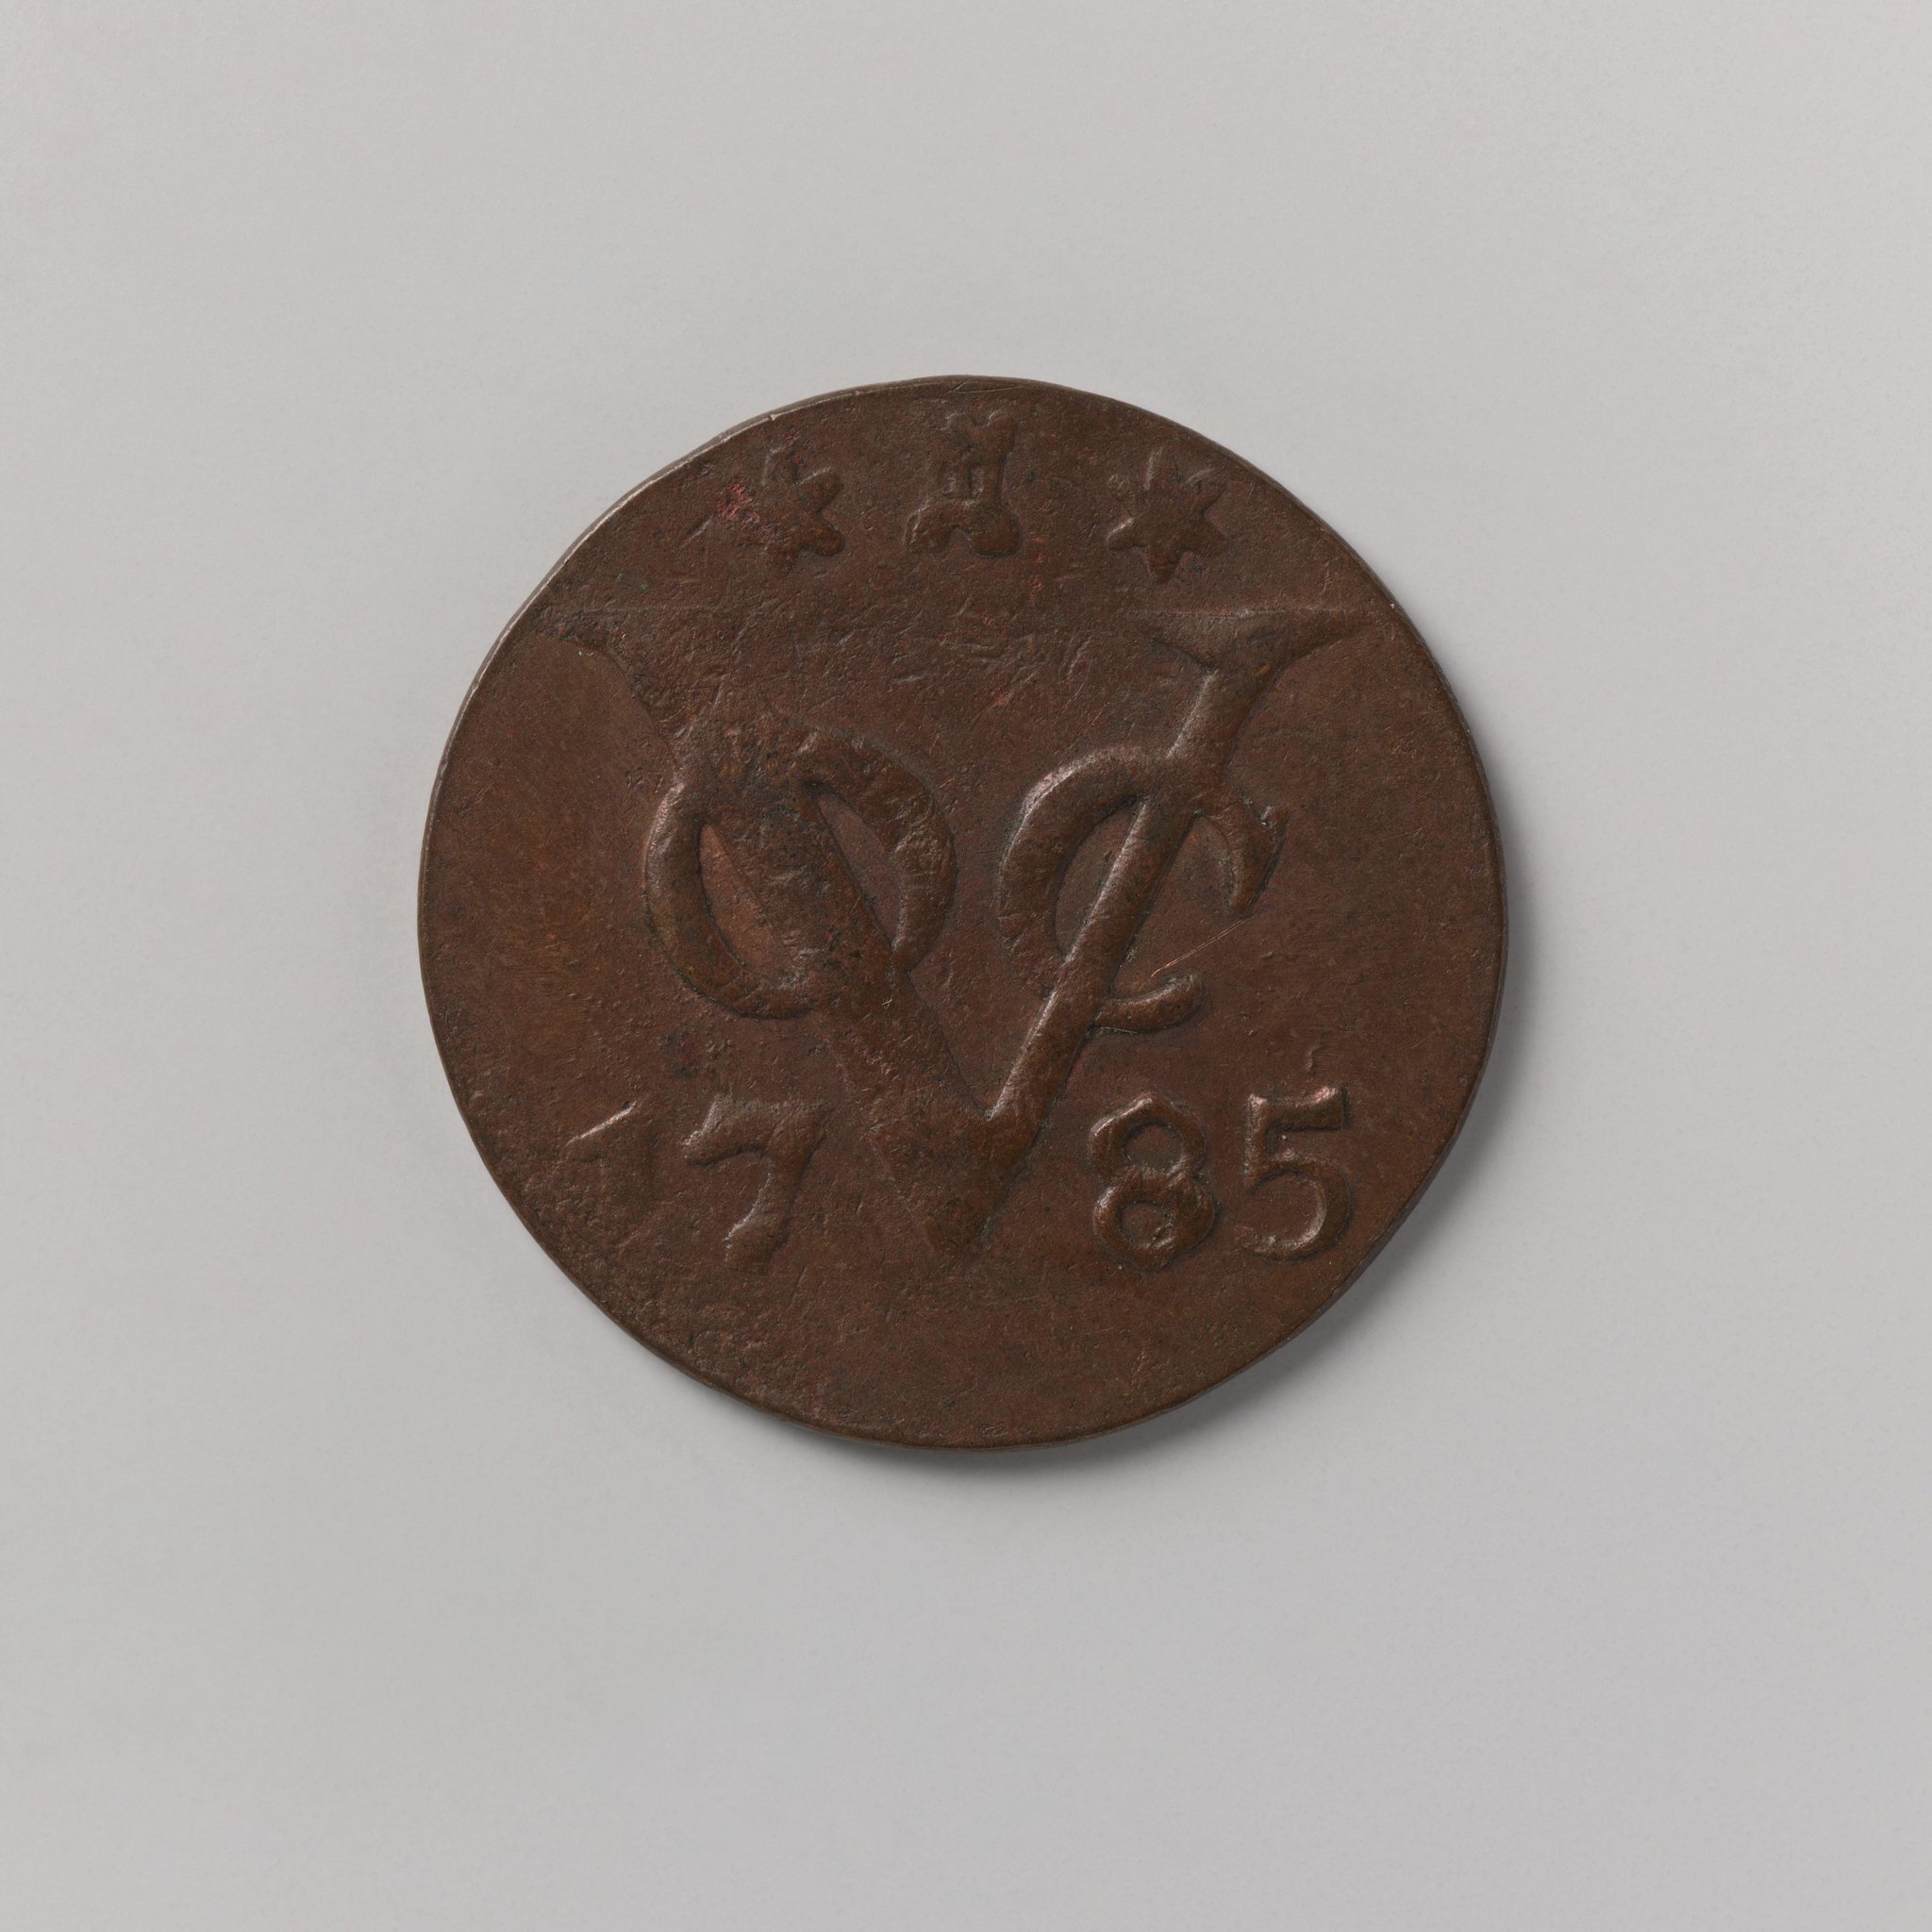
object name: coin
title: Duit van de VOC uit Zeeland, 1785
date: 1785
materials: copper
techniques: striking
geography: middelburg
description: Koperen munt. Voorzijde: gekroond wapenschild van Zeeland. Keerzijde: monogram van de VOC, waarboven muntteken en waaronder jaartal. Gladde rand.